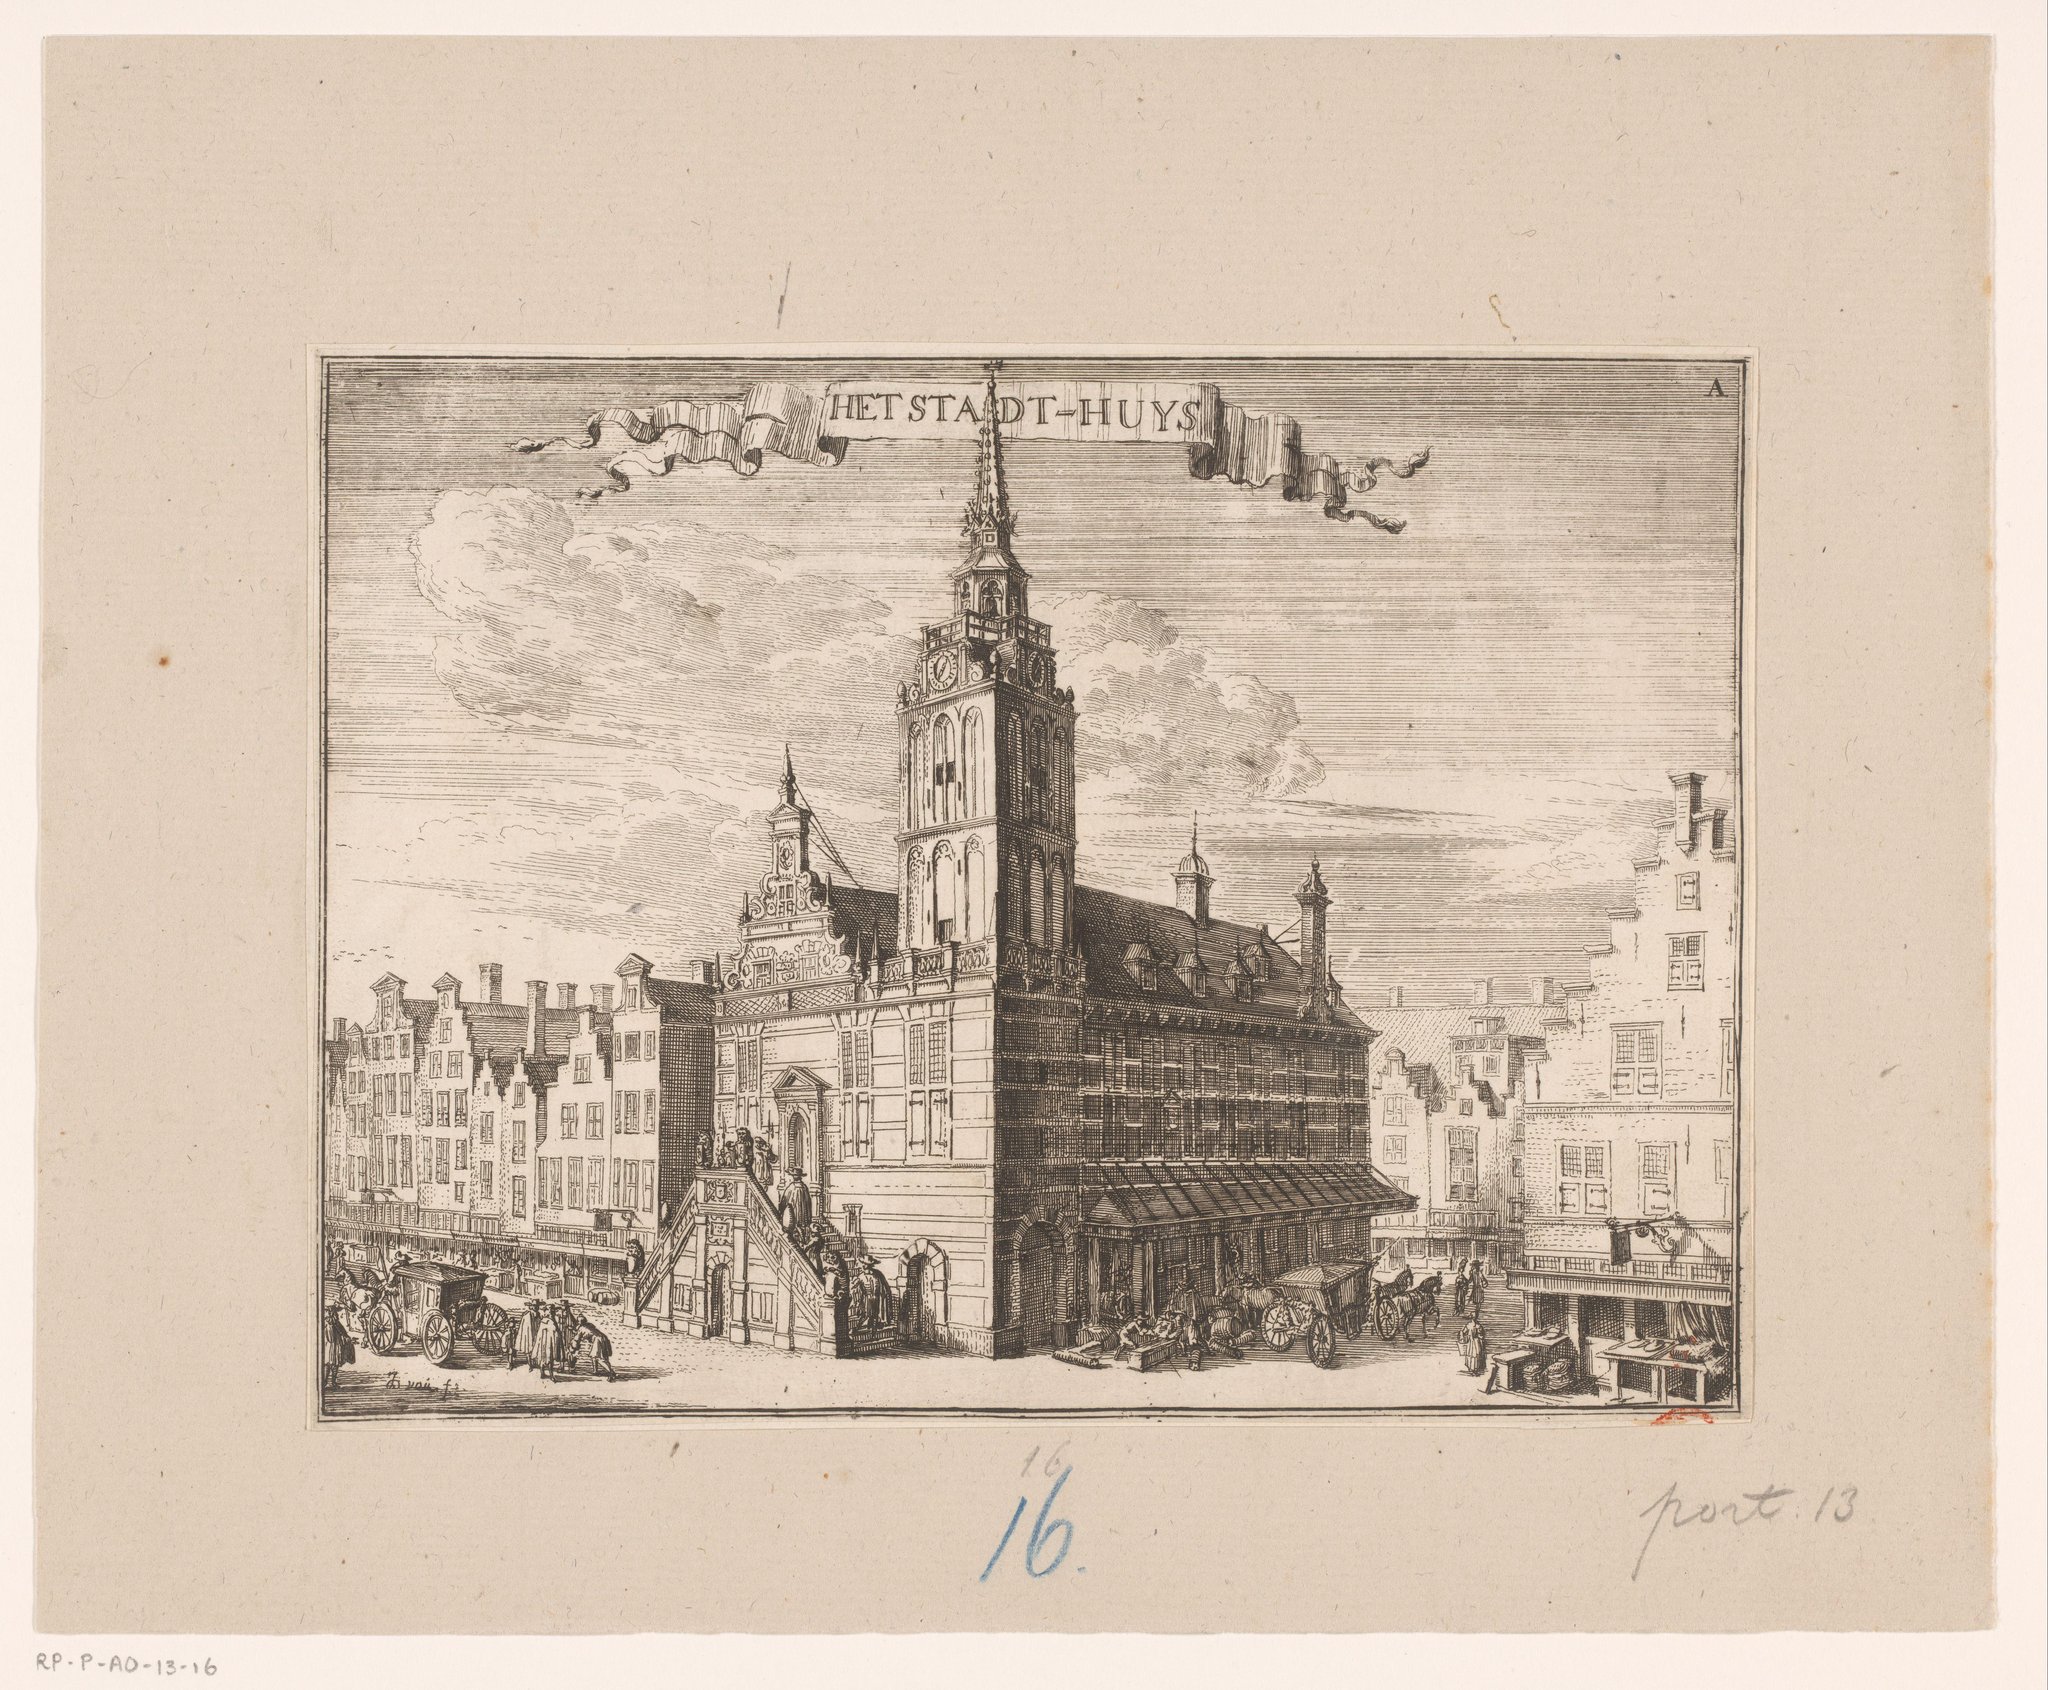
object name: print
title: Gezicht op het oude stadhuis te Rotterdam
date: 1694-1695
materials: paper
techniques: etching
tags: townhall, street (+ city(-scape) with figures, staffage)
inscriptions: collector's mark: Lugt 2228, collector's mark: Lugt 195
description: Prent oorspronkelijk gedrukt als onderdeel van de sierrand van 'Rotterdam met al syn gebouwen net op haer maet geteekent en gesneden', een wandkaart van Rotterdam, in prent gebracht door Romeyn de Hooghe en Johannes de Vouw. De rand om de plattegrond bestond uit wapenranden (langs de bovenkant en zijkanten), twaalf stadsgezichten (A-F langs de linker zijkant en G-M langs de rechter zijkant) en een stadsprofiel (langs de onderkant). Zie documentatie voor meer informatie. Zie ook RP-P-AO-13-87.